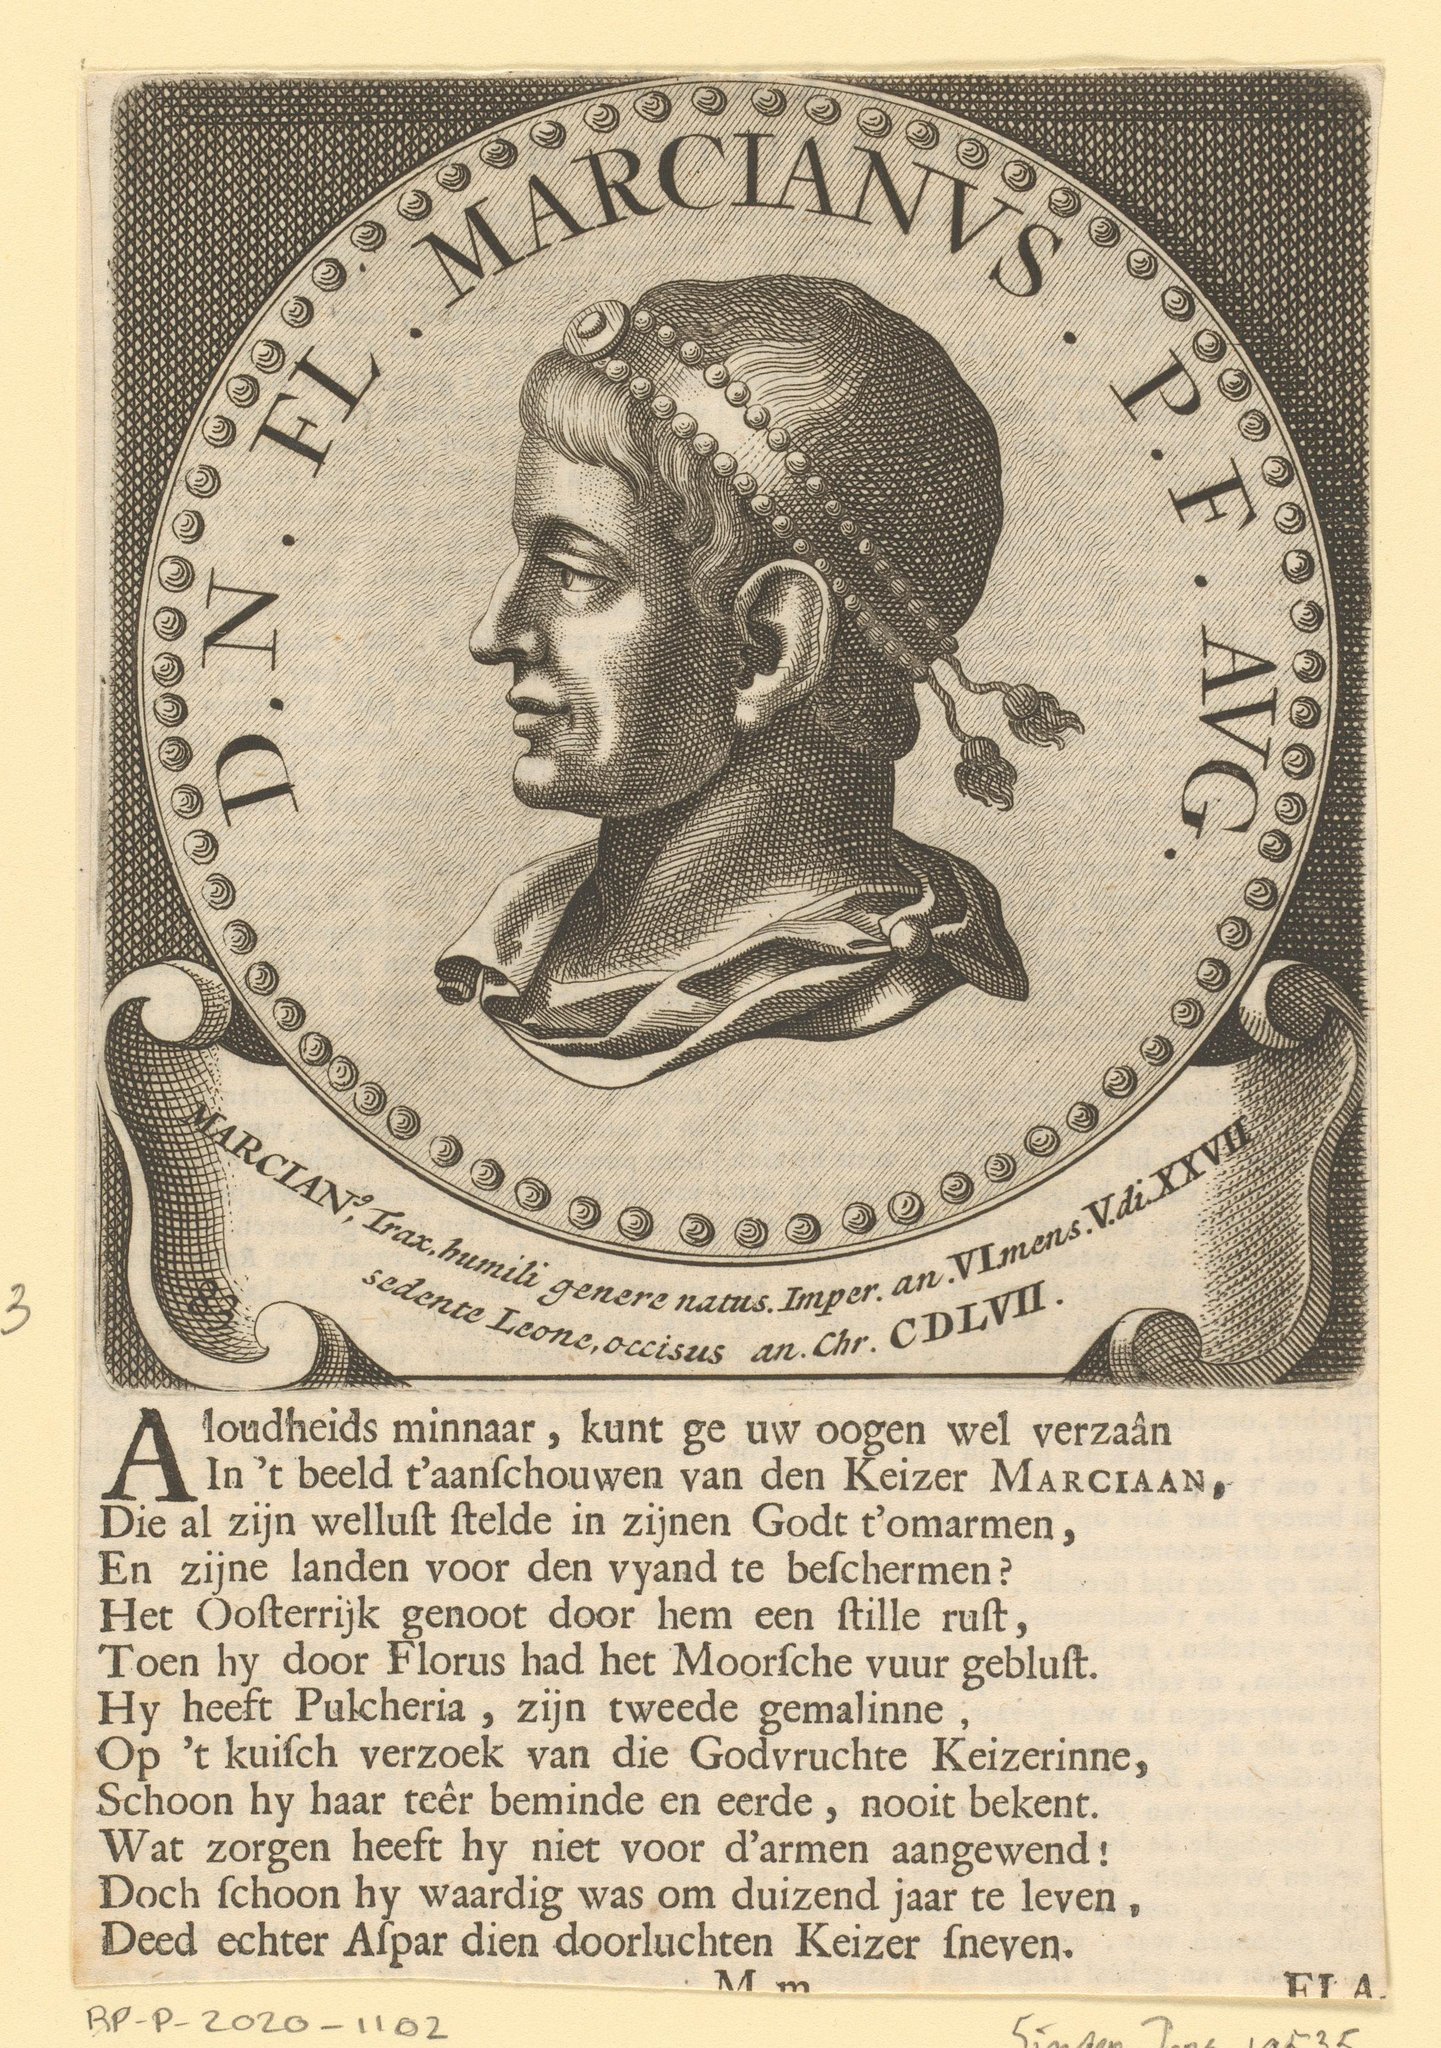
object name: print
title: Portret van keizer Marcianus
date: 1697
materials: paper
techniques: engraving, etching, letterpress printing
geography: utrecht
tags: historical persons, emperor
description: Prent uit: Bogaert, Abraham. De Roomsche monarchy, vertoont in de muntbeelden der westersche en oostersche keizeren (...). Utrecht: François Halma en Willem van de Water, 1697, p. 273. Eerste staat verschenen in een grotere prent met twaalf portretten, gedateerd 1695.